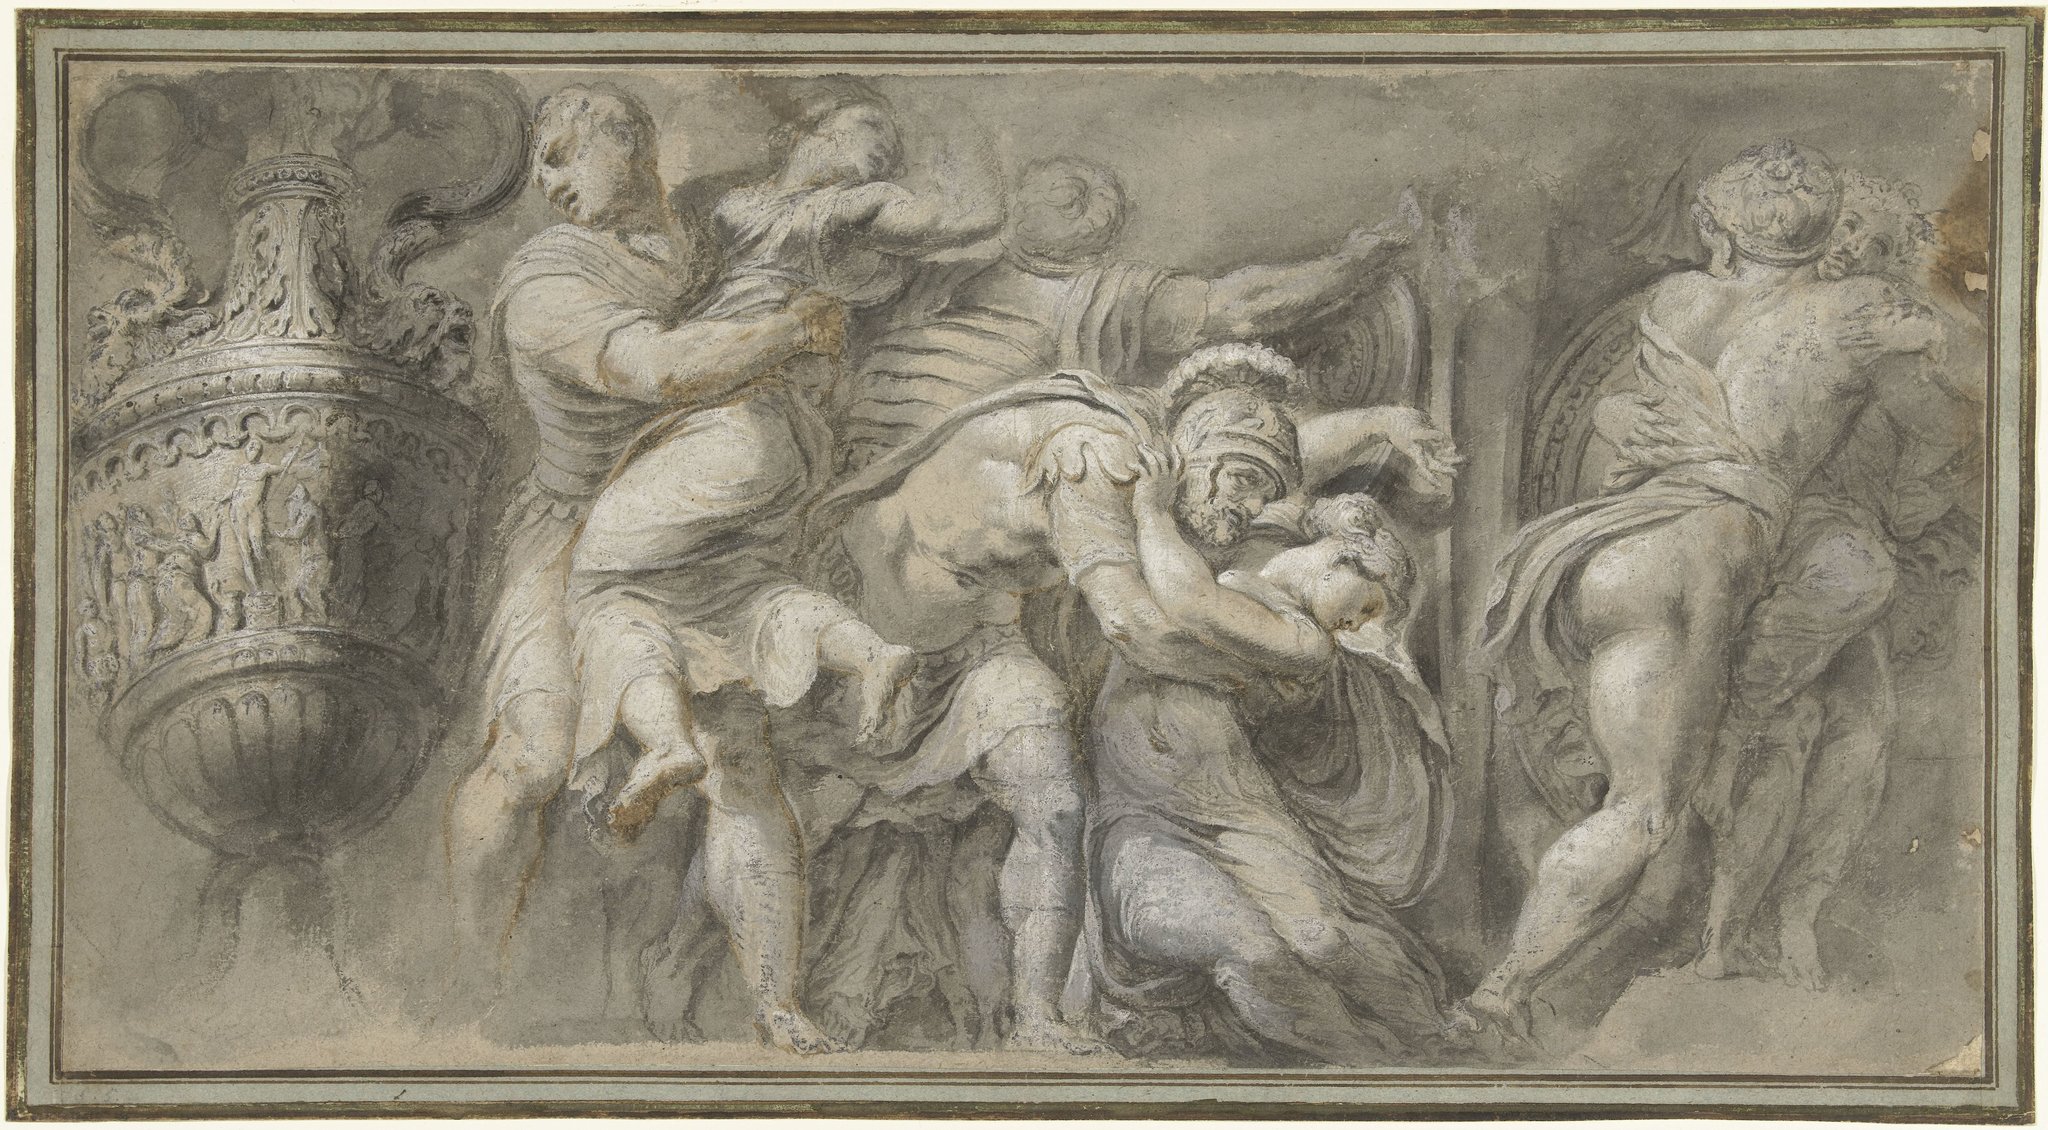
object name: drawing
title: Sabijnse maagdenroof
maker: Anonymous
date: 1510-1600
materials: ink, paper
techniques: brush, pen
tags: rape of the sabine women: they are carried off by romulus and his men during a feast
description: De Sabijnse maagdenroof; op de voorgrond links een antieke vaas.